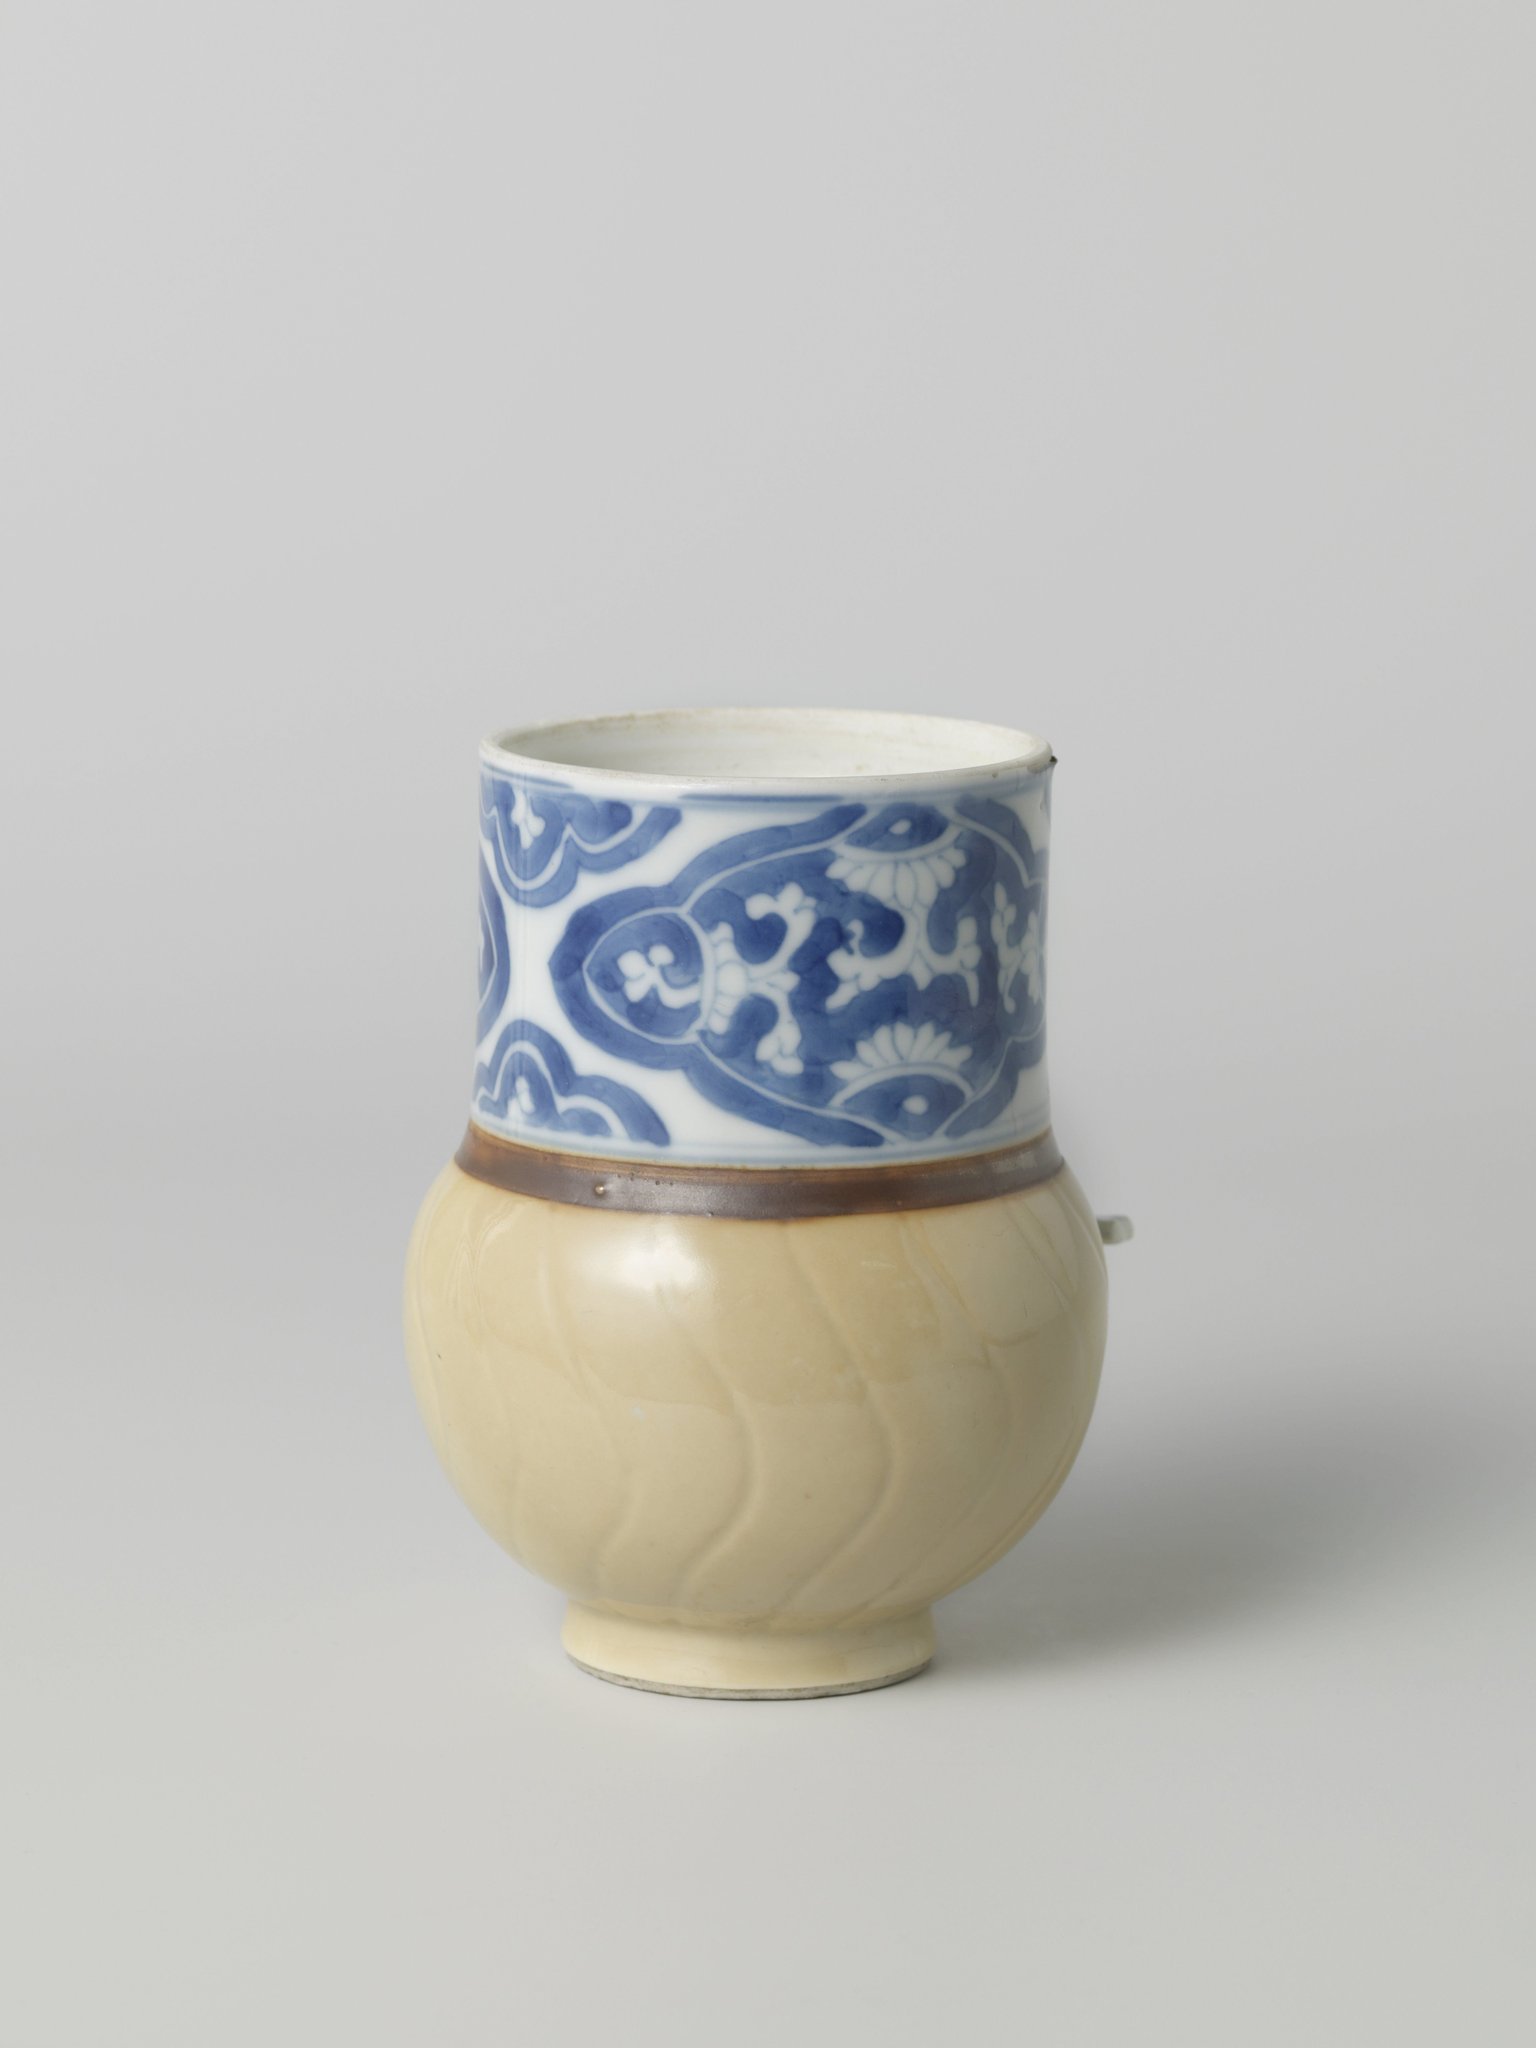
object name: cup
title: Tankard with light brown and panels with flower scrolls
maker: Anonymous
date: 1700-1724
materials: cobalt, glaze, paint, porcelain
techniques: firing, turning, vitrification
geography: china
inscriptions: mark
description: Bierpul van porselein, beschilderd in onderglazuur blauw en met café-au-lait glazuur. Het onderste, bolvormige deel van het lichaam is met licht ingegrifte lijnen en bedekt met een lichtbruin glazuur, hierboven een bruine band; het bovenste, rechte deel van het lichaam met gelobde cartouches in onderglazuur blauw met bloemranken in reserve. Gemerkt op de onderzijde met een artemisiablad. Oor ontbreekt. Monochroom bruin met blauw-wit.